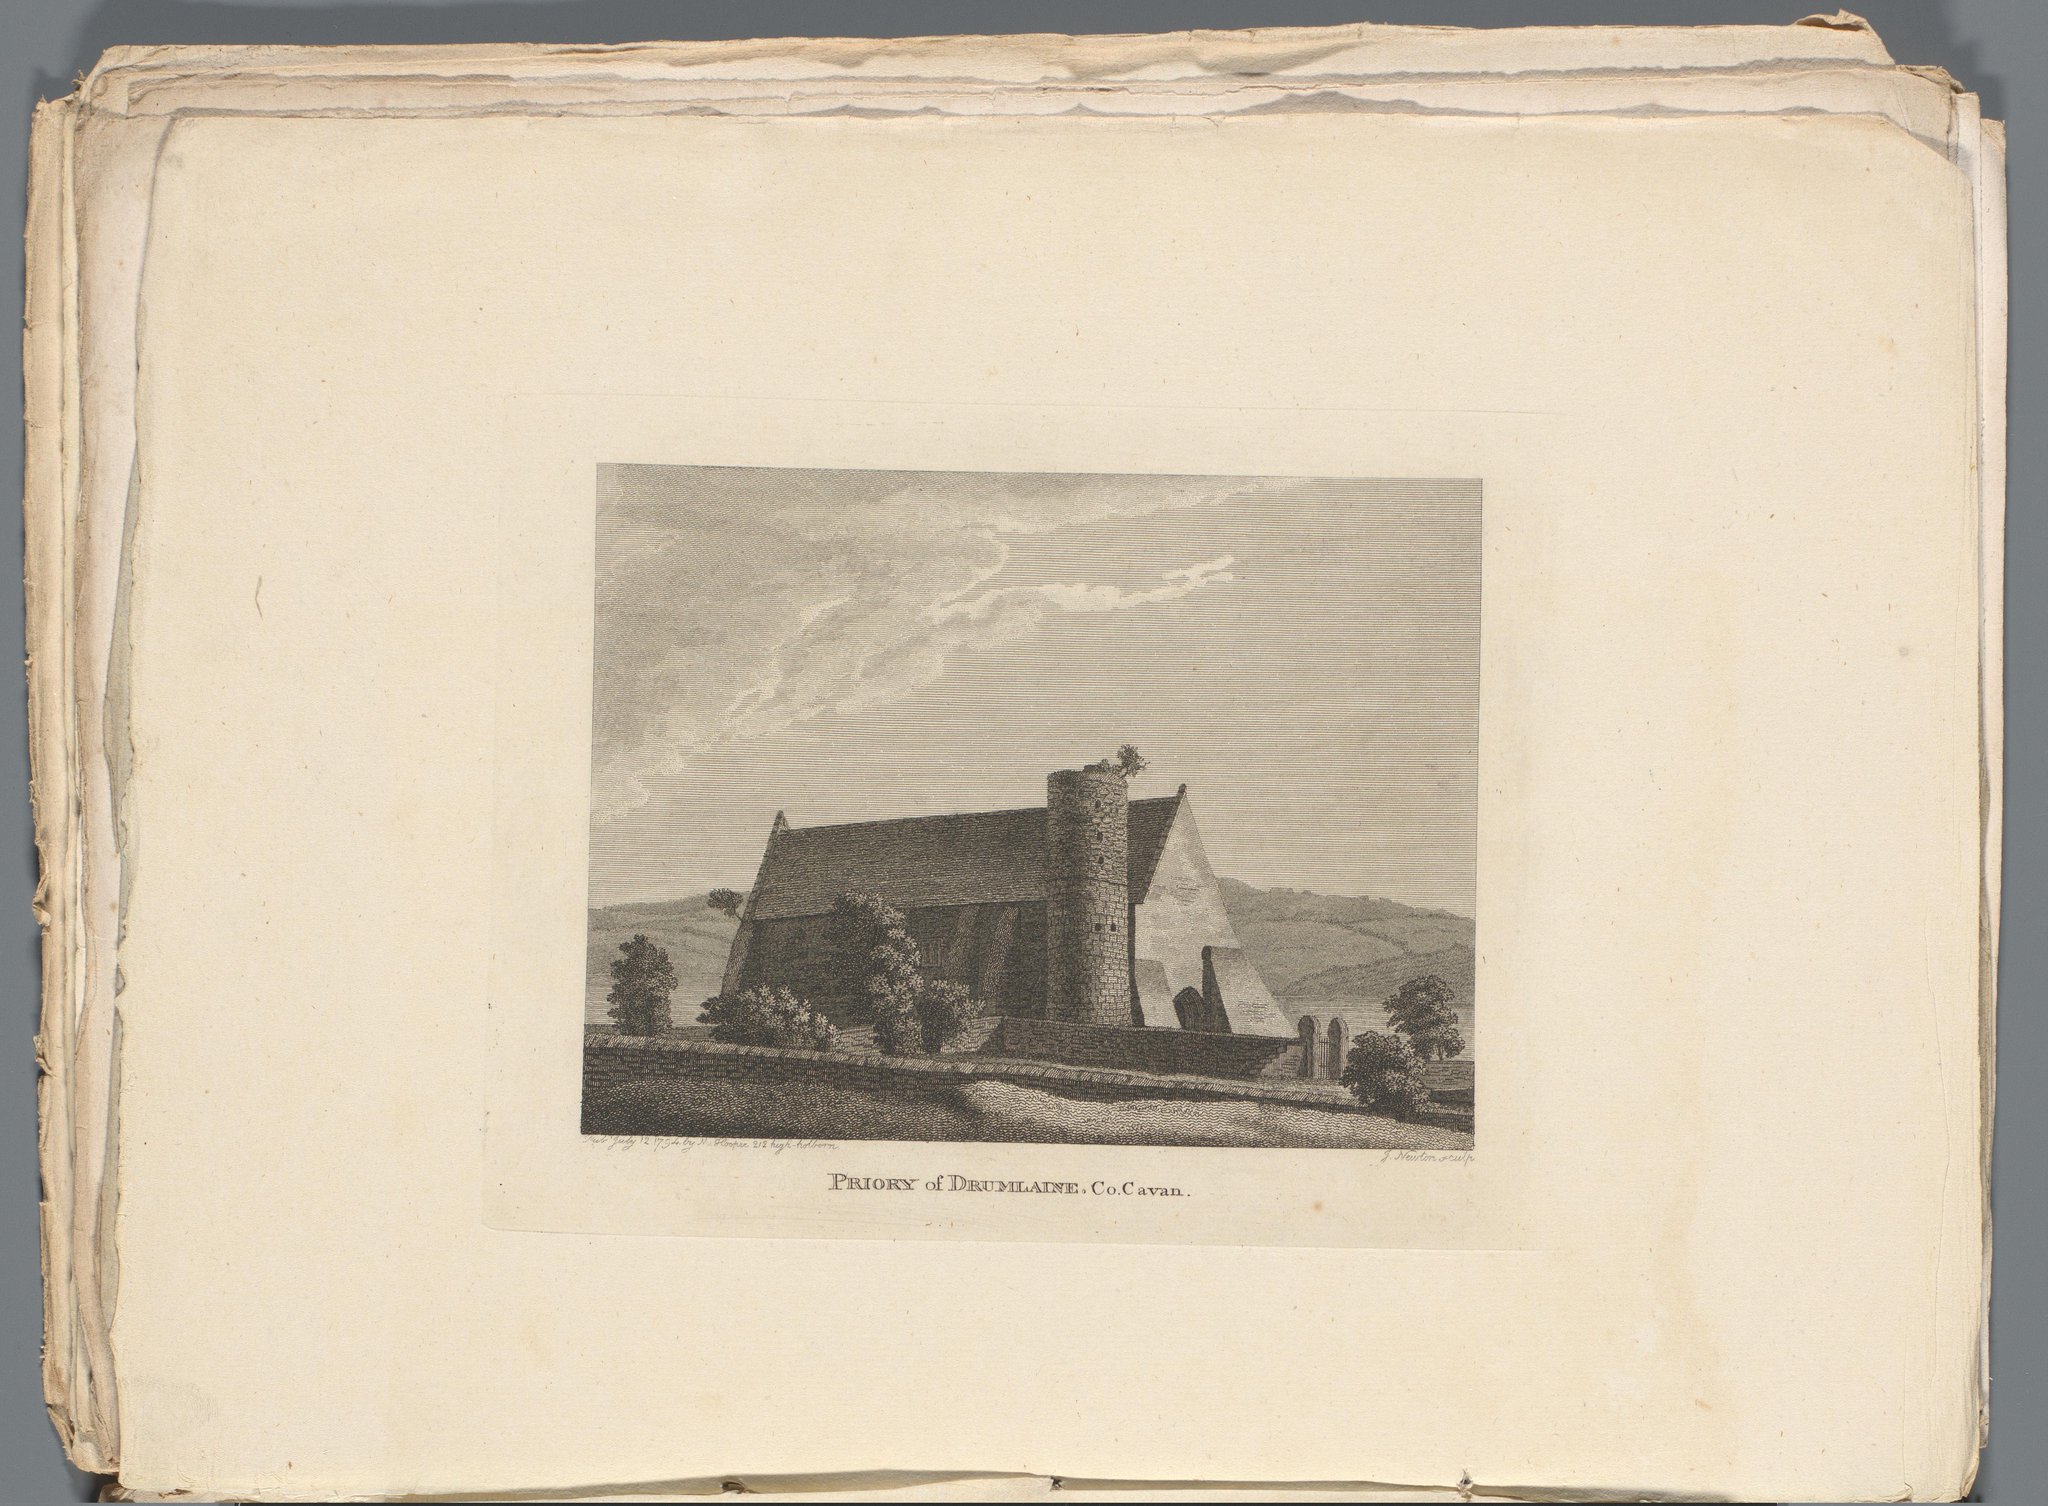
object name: book illustration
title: Gezicht op de priorij van Drumlane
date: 1794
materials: paper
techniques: etching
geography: london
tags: city-view, and landscape with man-made constructions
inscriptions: date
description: Prent verschenen in: Grose, Francis. The antiquities of Ireland. Londen: S. Hooper, 1795, dl. 2.